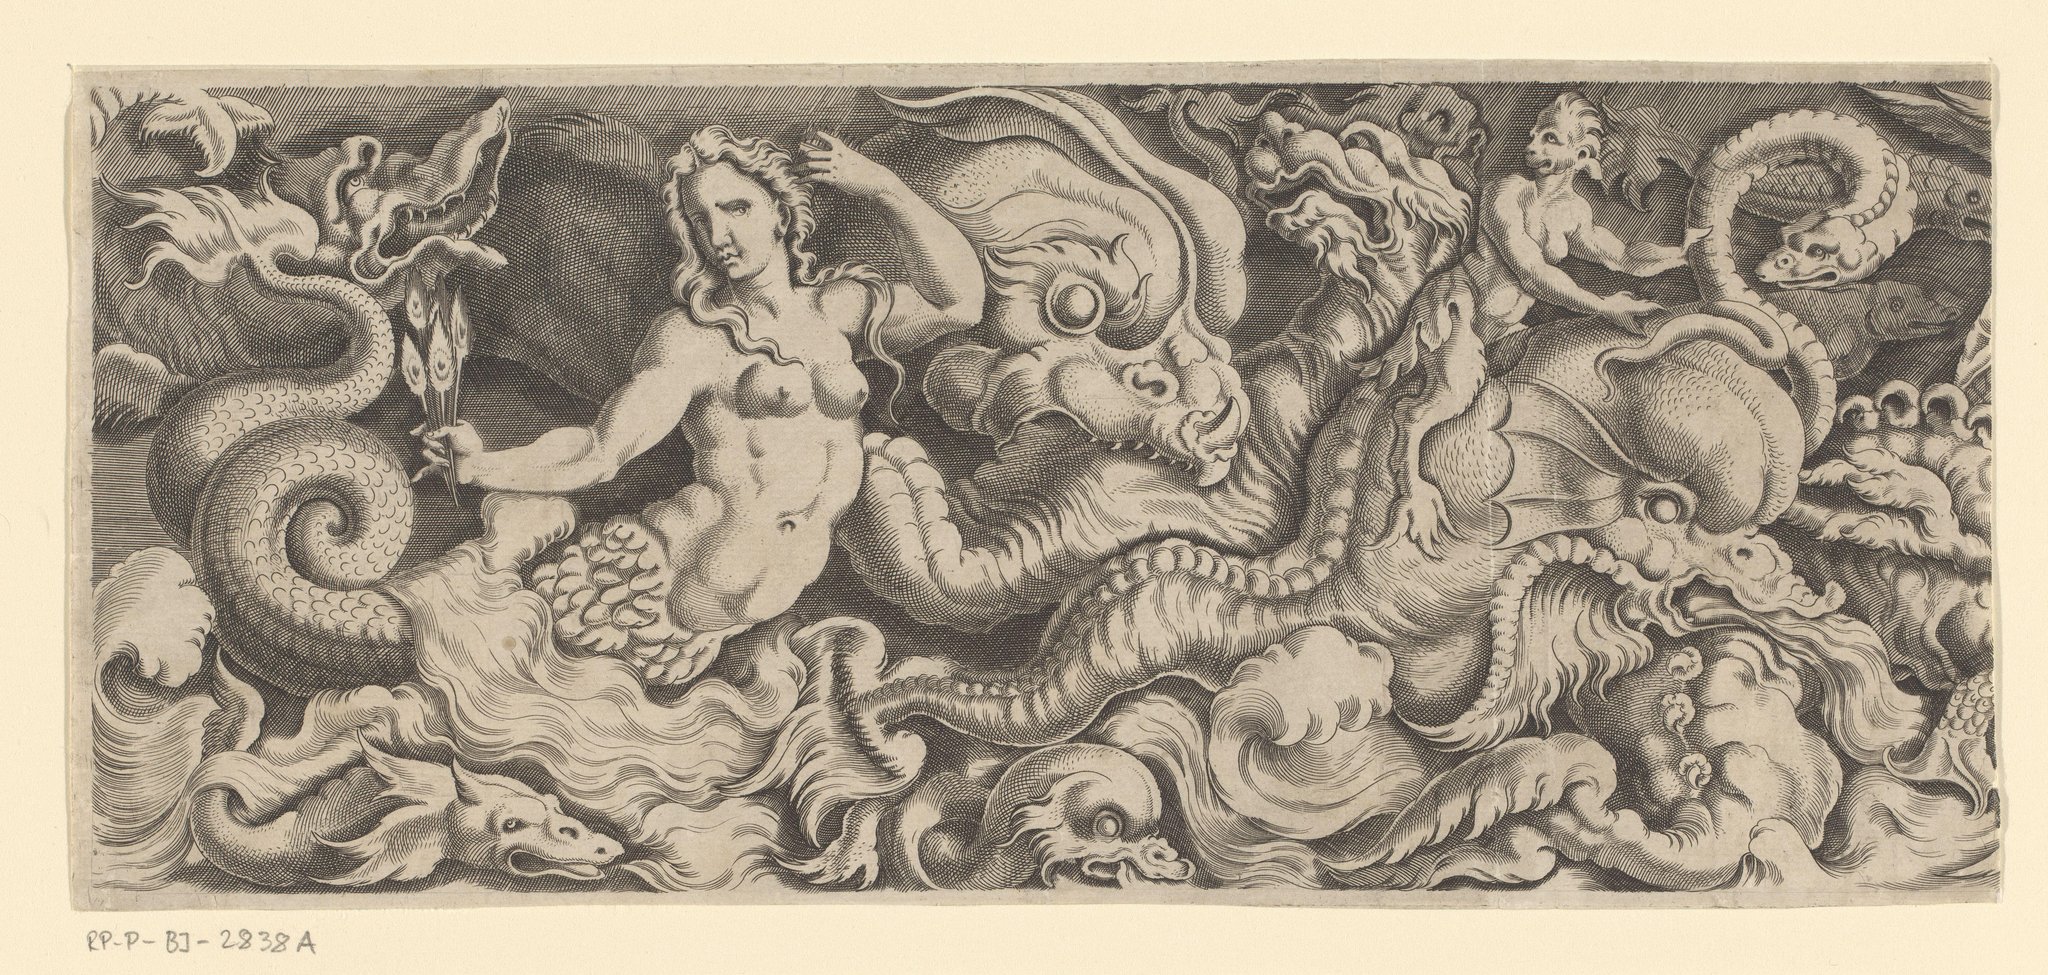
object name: print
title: Fries met de triomf van Neptunus (linker deel)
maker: cornelis bos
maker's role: print maker, printer, publisher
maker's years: 1510-1566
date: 1548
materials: paper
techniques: engraving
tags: (story of) neptune (poseidon), merman - aa - mermaid, siren, fabulous animals ~ fishes, fabulous animals ~ reptiles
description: Linkerdeel van een fries met de triomf van de God Neptunus. Verschillende fabeldieren zijn in elkaar verwrongen. Links zwemt een meermin die pauwenveren in haar hand houdt.